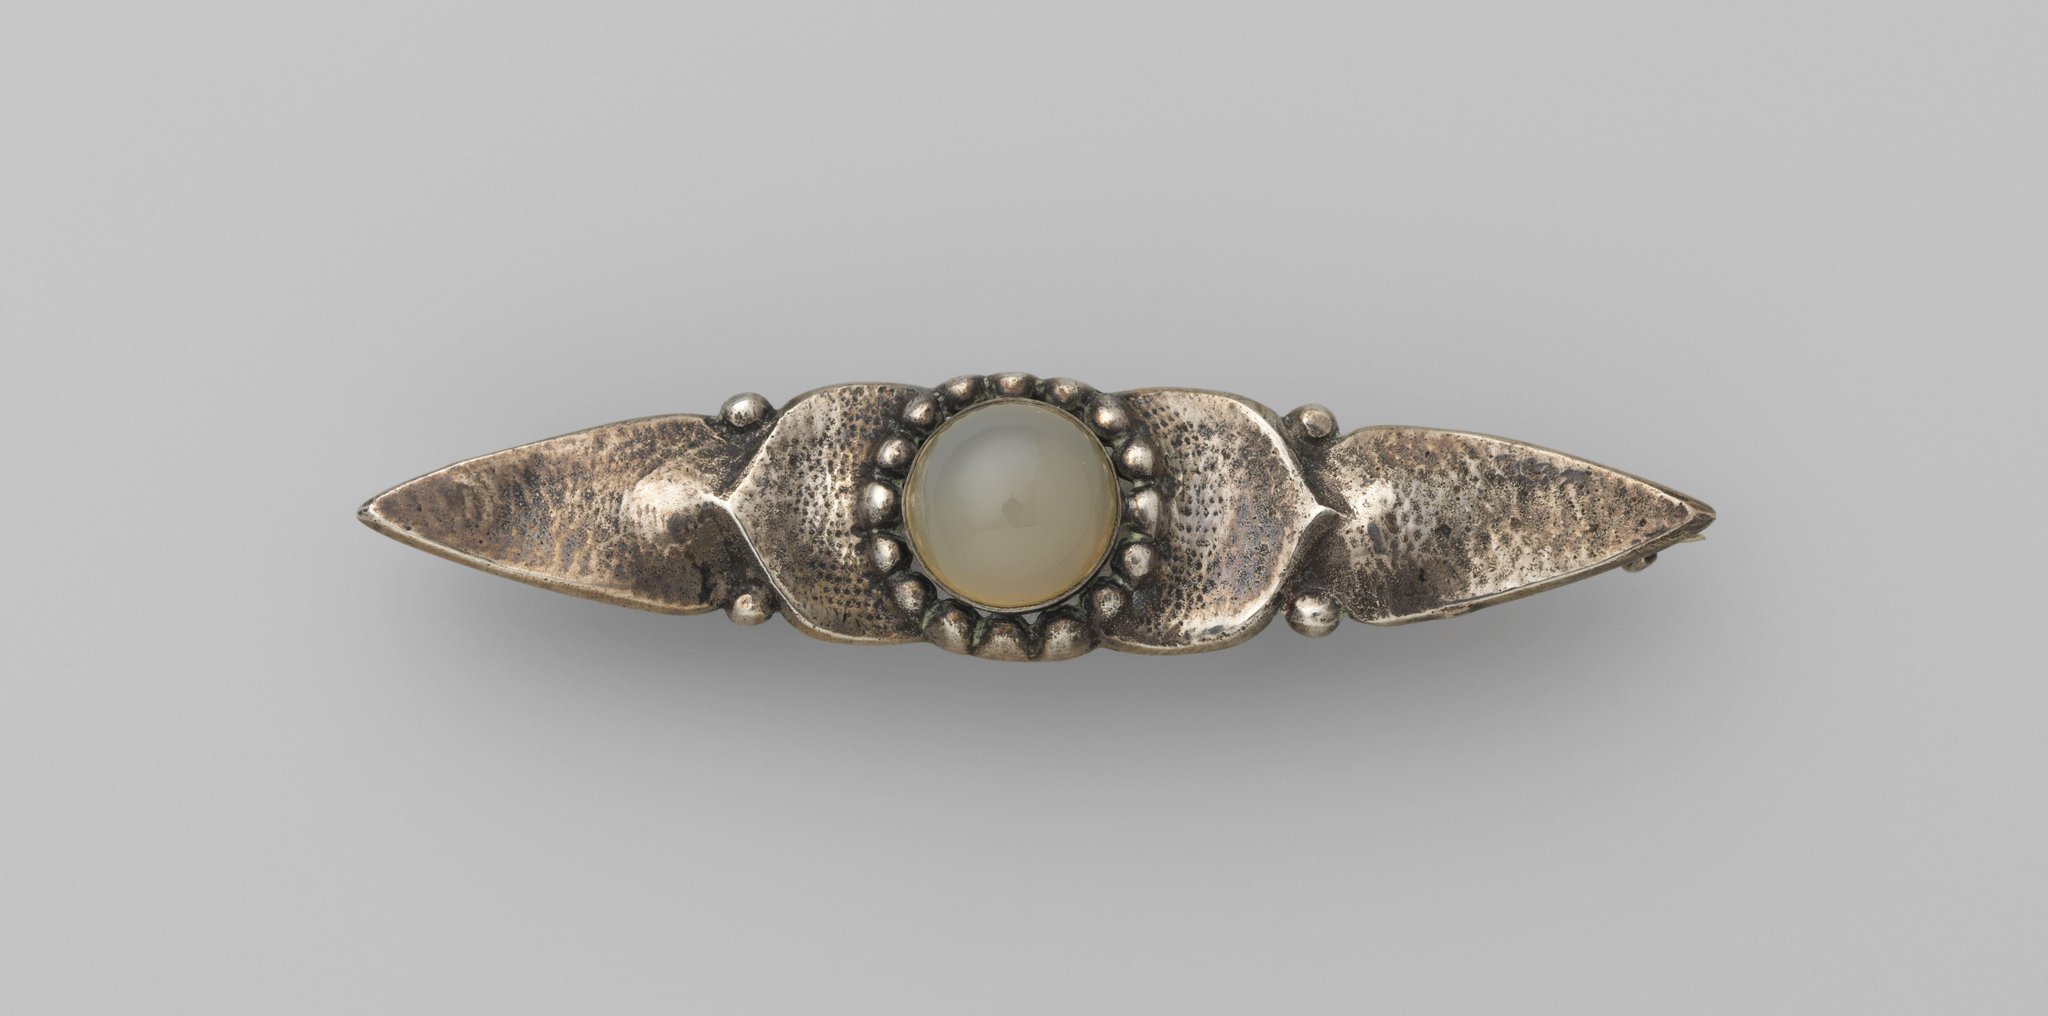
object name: brooch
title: Brochette van zilver en agaat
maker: Anonymous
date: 1930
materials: stone, silver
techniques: grinding, hammering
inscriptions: maker's mark, : ‘I’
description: Brochette van gehamerd zilver met een cabochon geslepen witte agaat voorzien van een haaksluiting.